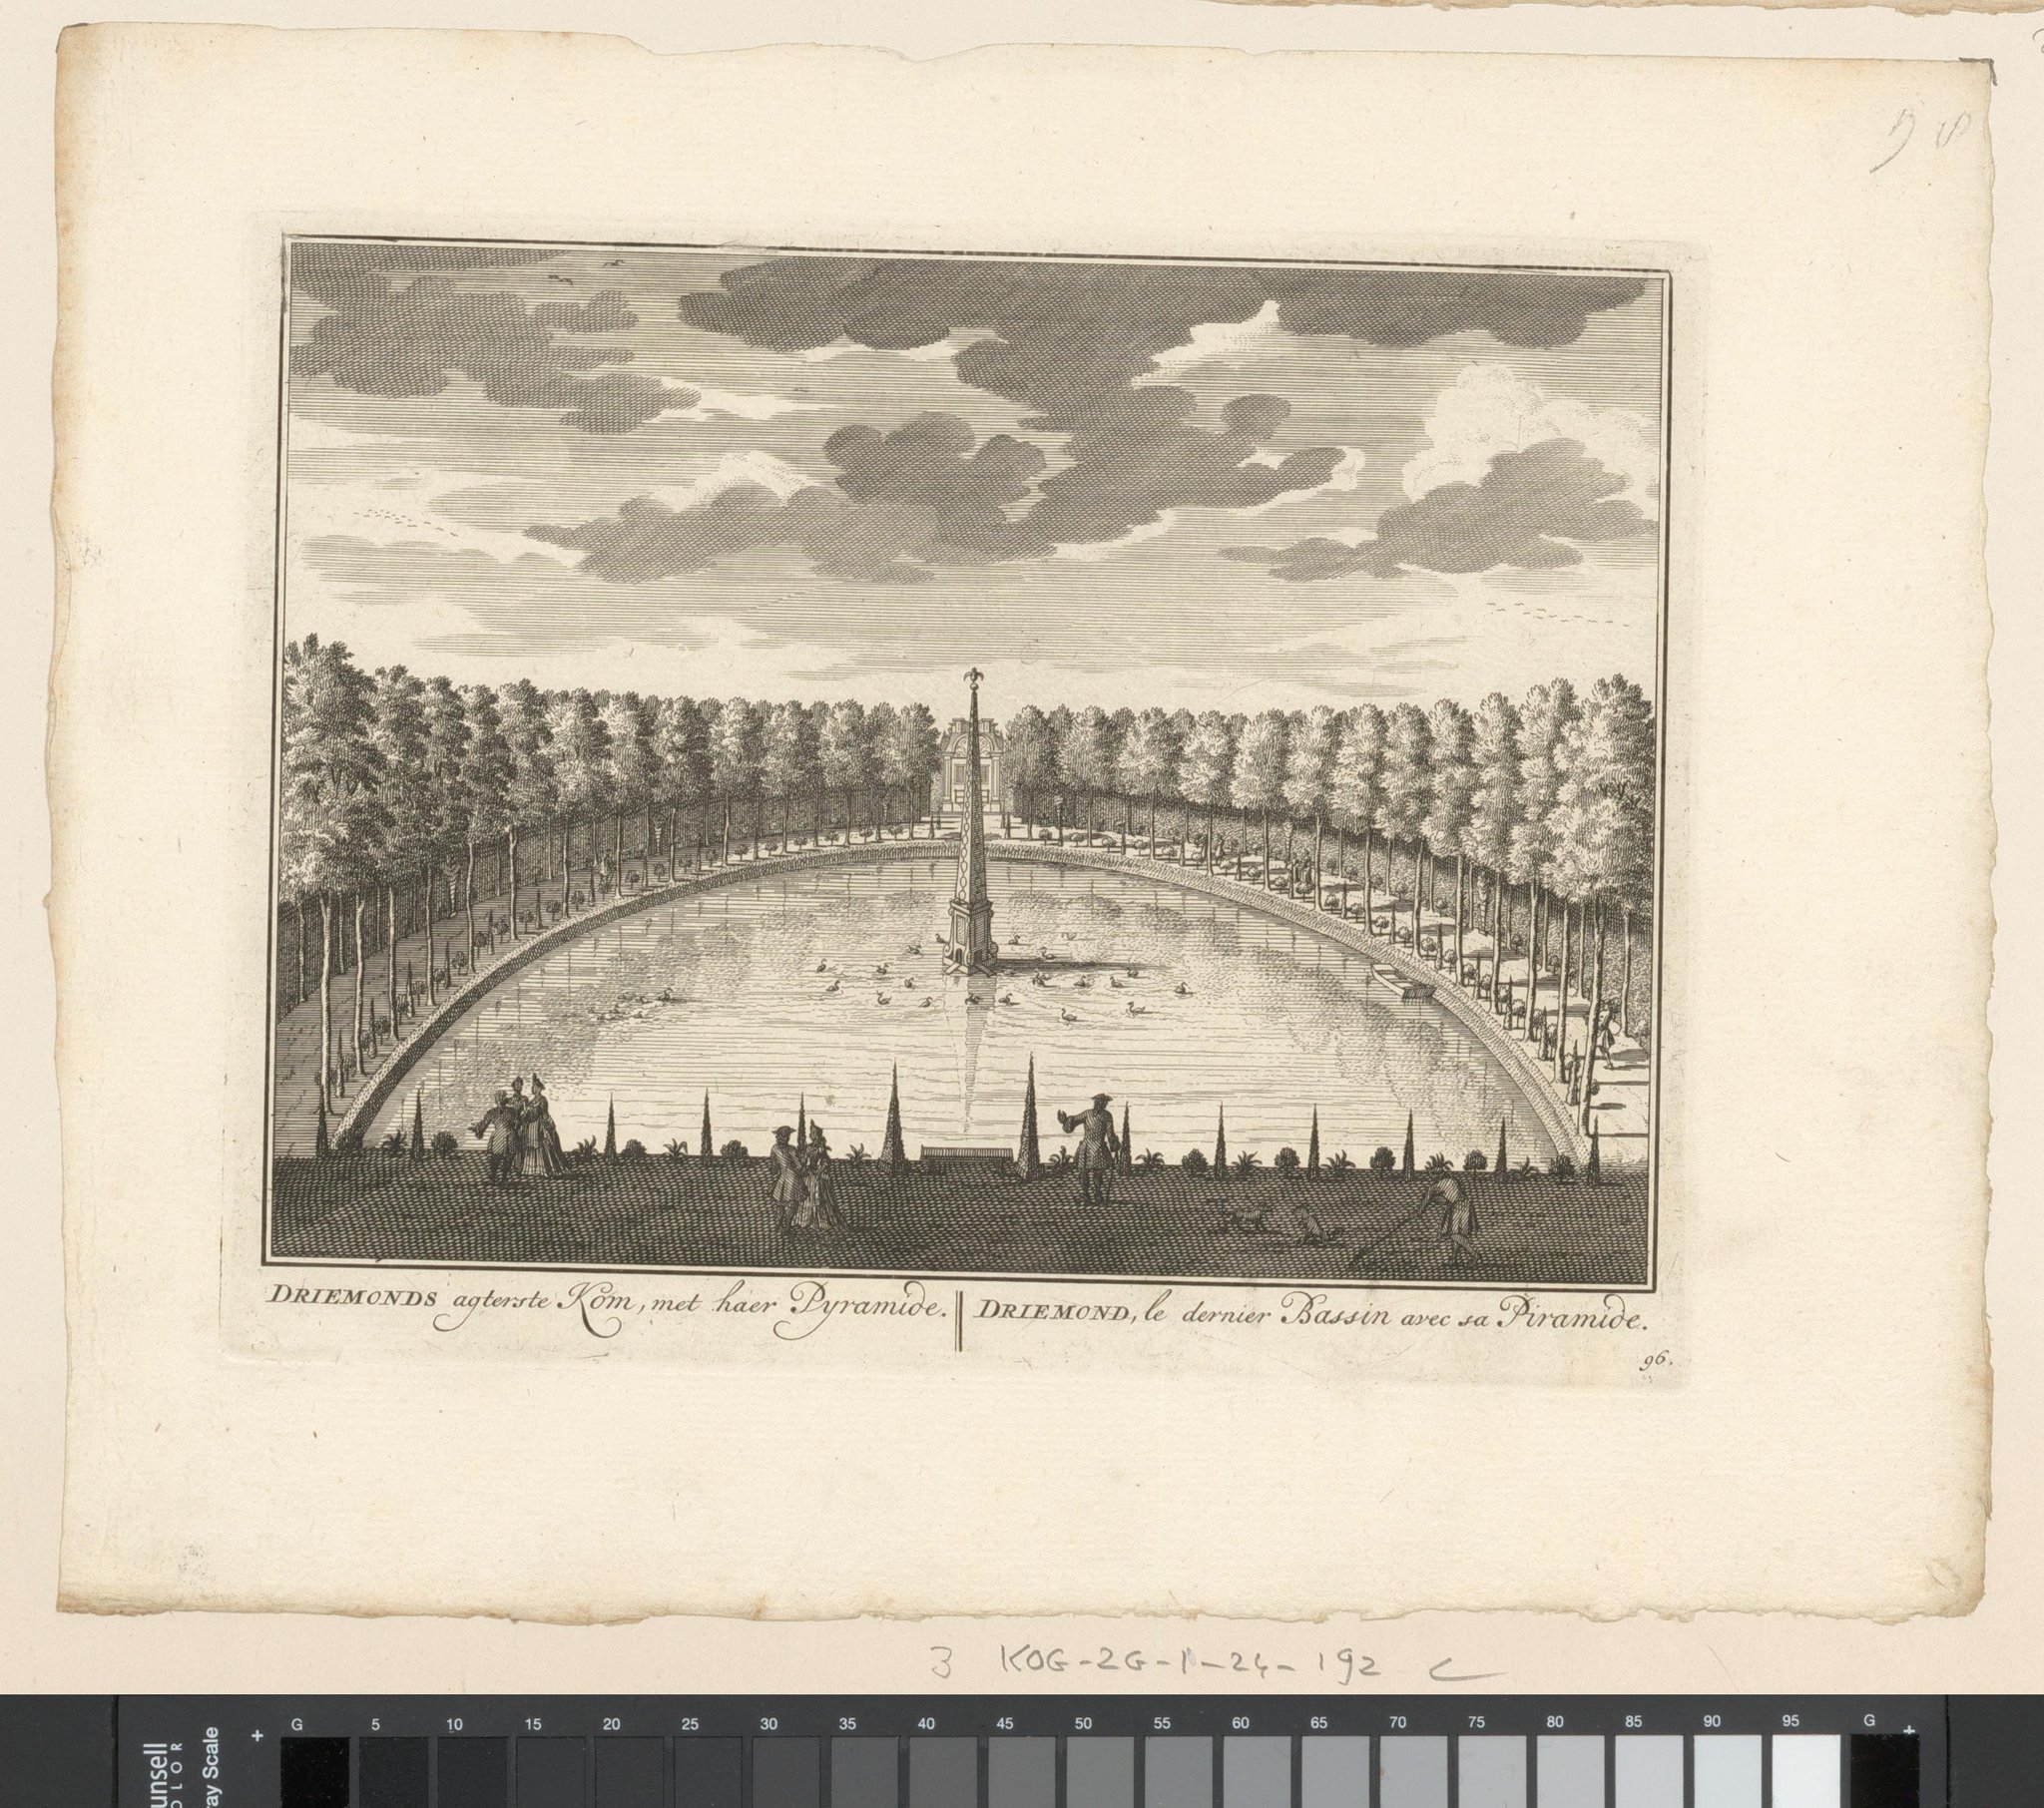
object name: print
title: Driemonds agterste Kom, met haer Pyramide / Driemond, le dernier Bassin avec sa Piramide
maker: hendrik de leth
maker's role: draughtsman, print maker, publisher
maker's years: 1703-1766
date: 1729-1732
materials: paper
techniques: engraving, etching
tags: french or architectonic garden; formal garden, garden pond, country-house, amsterdam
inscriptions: stamp, stamp, collector's mark: Lugt 1641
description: Prent mogelijk uit: Brouërius van Nidek, Matthaeus. Het zegepralend Kennemerland, vertoond in 100 heerlyke gezichten. Amsterdam: Jan Roman, s.a. Of uit: Brouërius van Nidek, Matthaeus. Het zegepralend Kennemerland, vertoond in veele heerlyke gezichten. Amsterdam: Andries en Hendrik de Leth, s.a [1729-1732]. Of uit: Brouërius van Nidek, Matthaeus. Het zegepralend Kennemerland, vertoond in veele heerlyke gezichten. Amsterdam: Jan Roman, s.a.